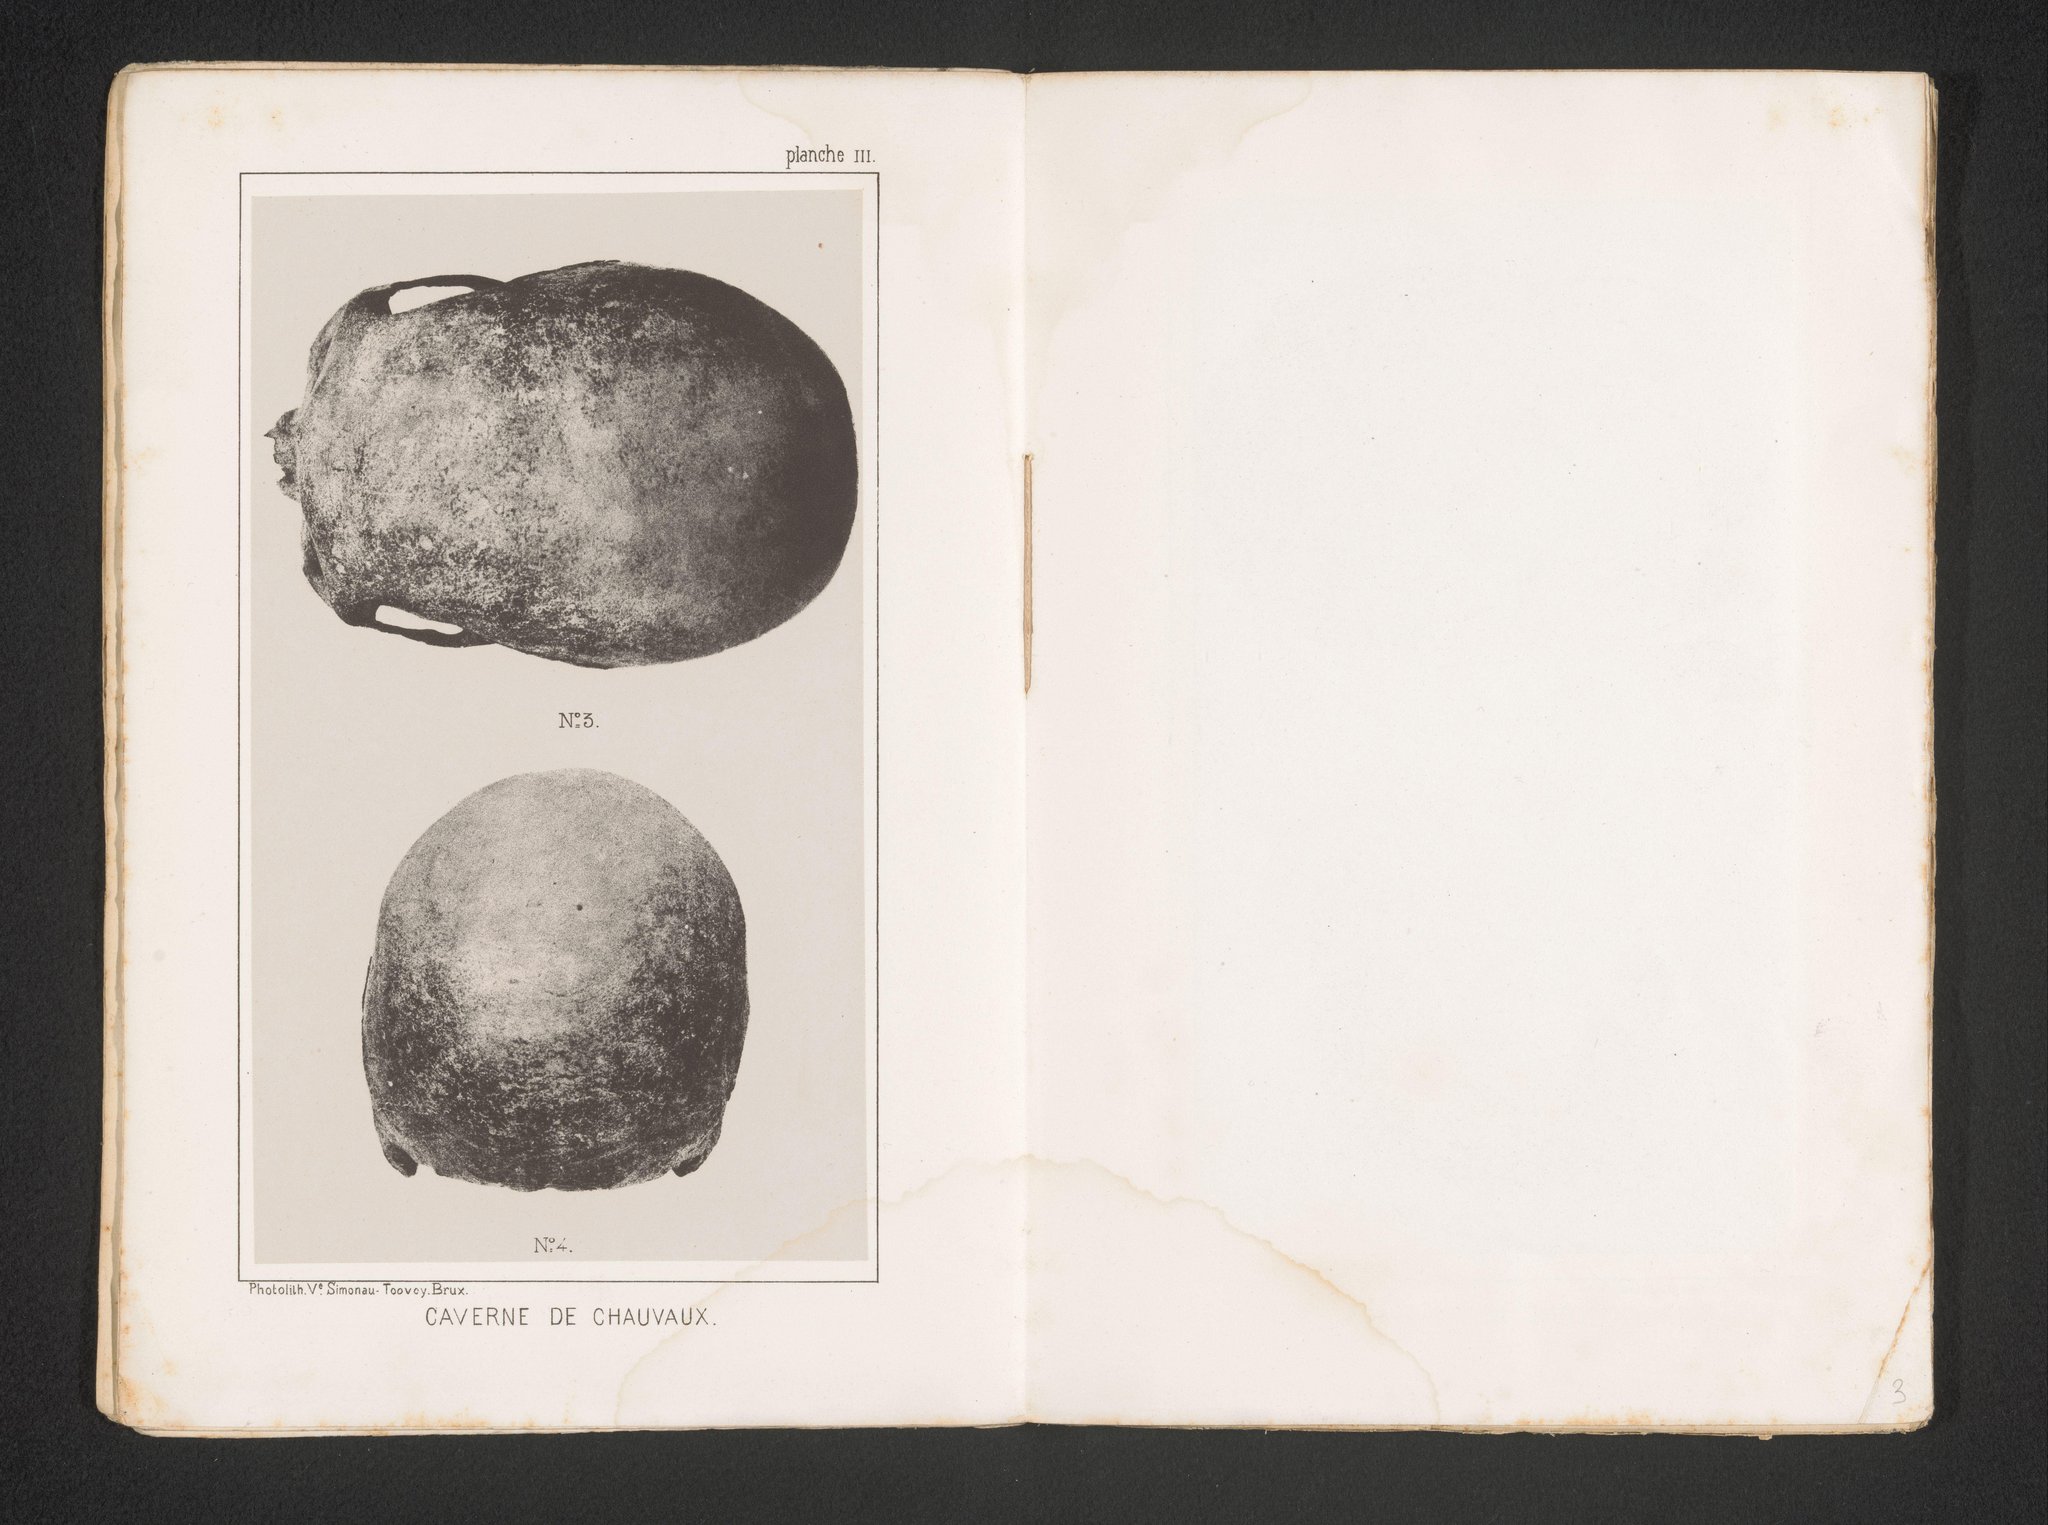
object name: photomechanical print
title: Caverne de Chauvaux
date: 1870-1875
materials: paper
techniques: photolithography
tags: (human) skull